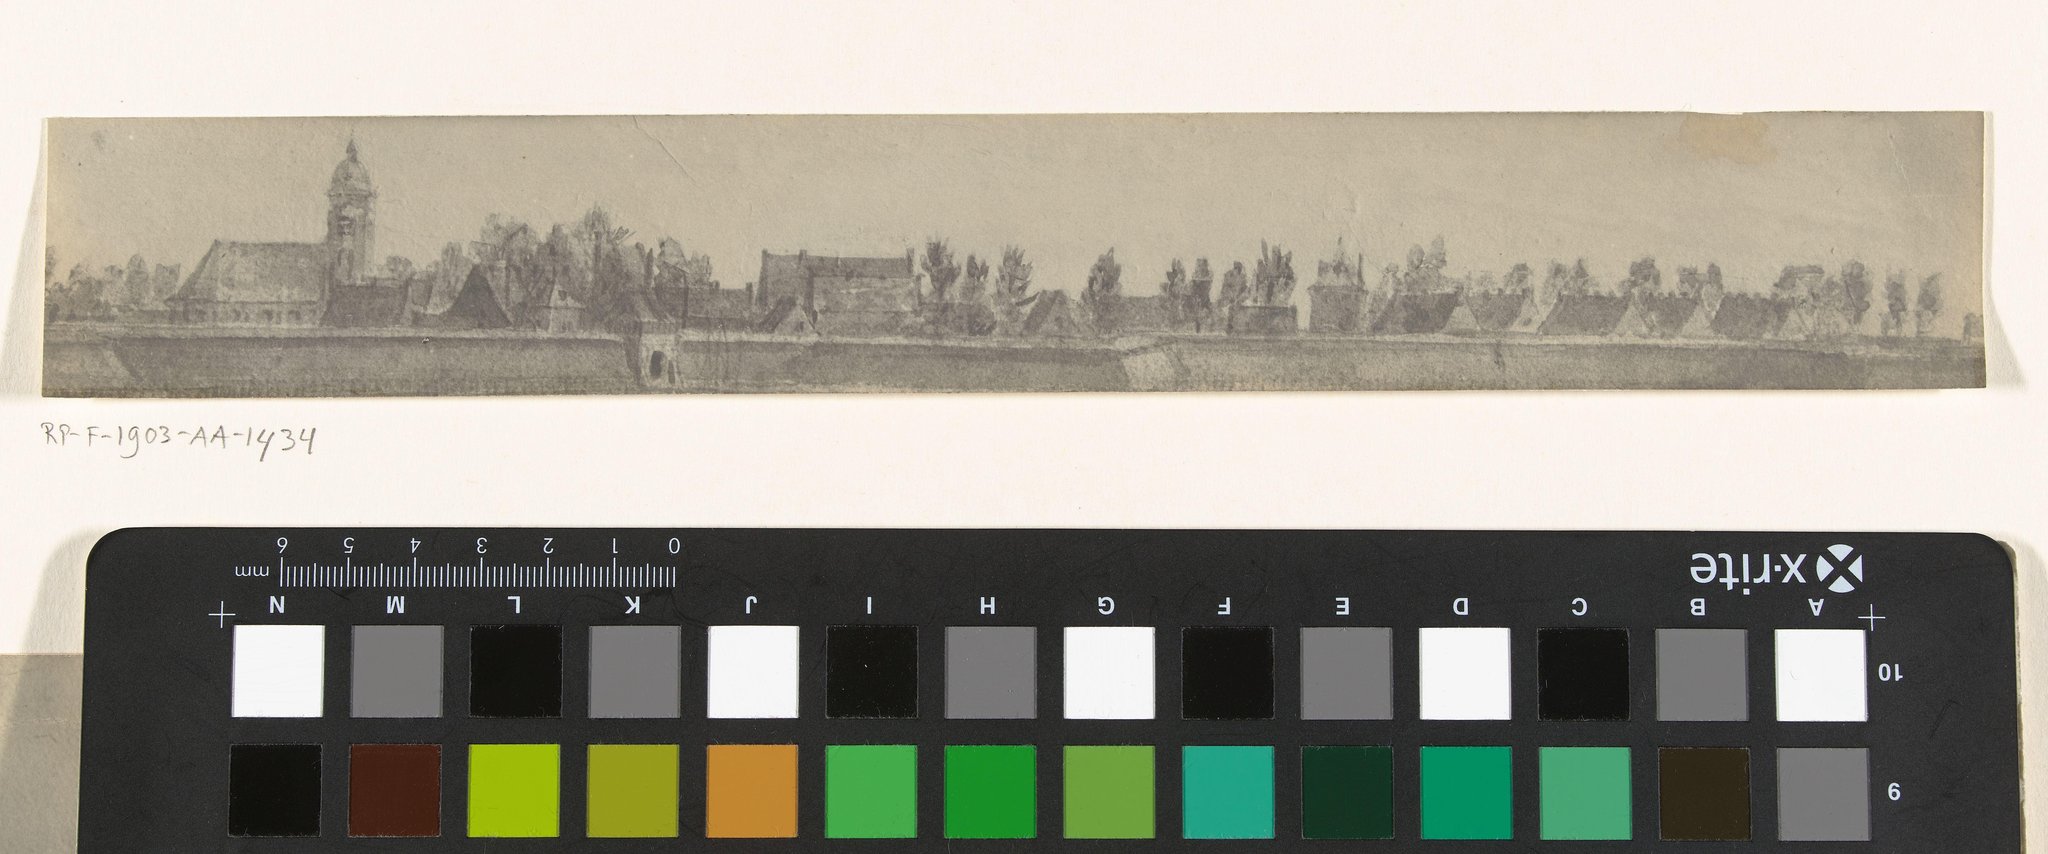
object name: photograph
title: Foto's van tekeningen van de Franse inval in de Nederlanden in 1672 door Adam Frans van der Meulen bewaard in de Manufacture des Gobelins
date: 1900-1903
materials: paper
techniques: gelatin silver print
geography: france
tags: lodewijk xiv (koning van frankrijk), prospect of city, town panorama, silhouette of city, rampjaar (disaster year)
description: Niet in Frederik Muller; door het RPK toegevoegd nummer. Onderdeel van een groep van ca. 50 foto's van tekeningen van de Franse inval in de Nederlanden in 1672 door Adam Frans van der Meulen, bewaard in de Manufacture Nationale des Gobelins te Parijs.